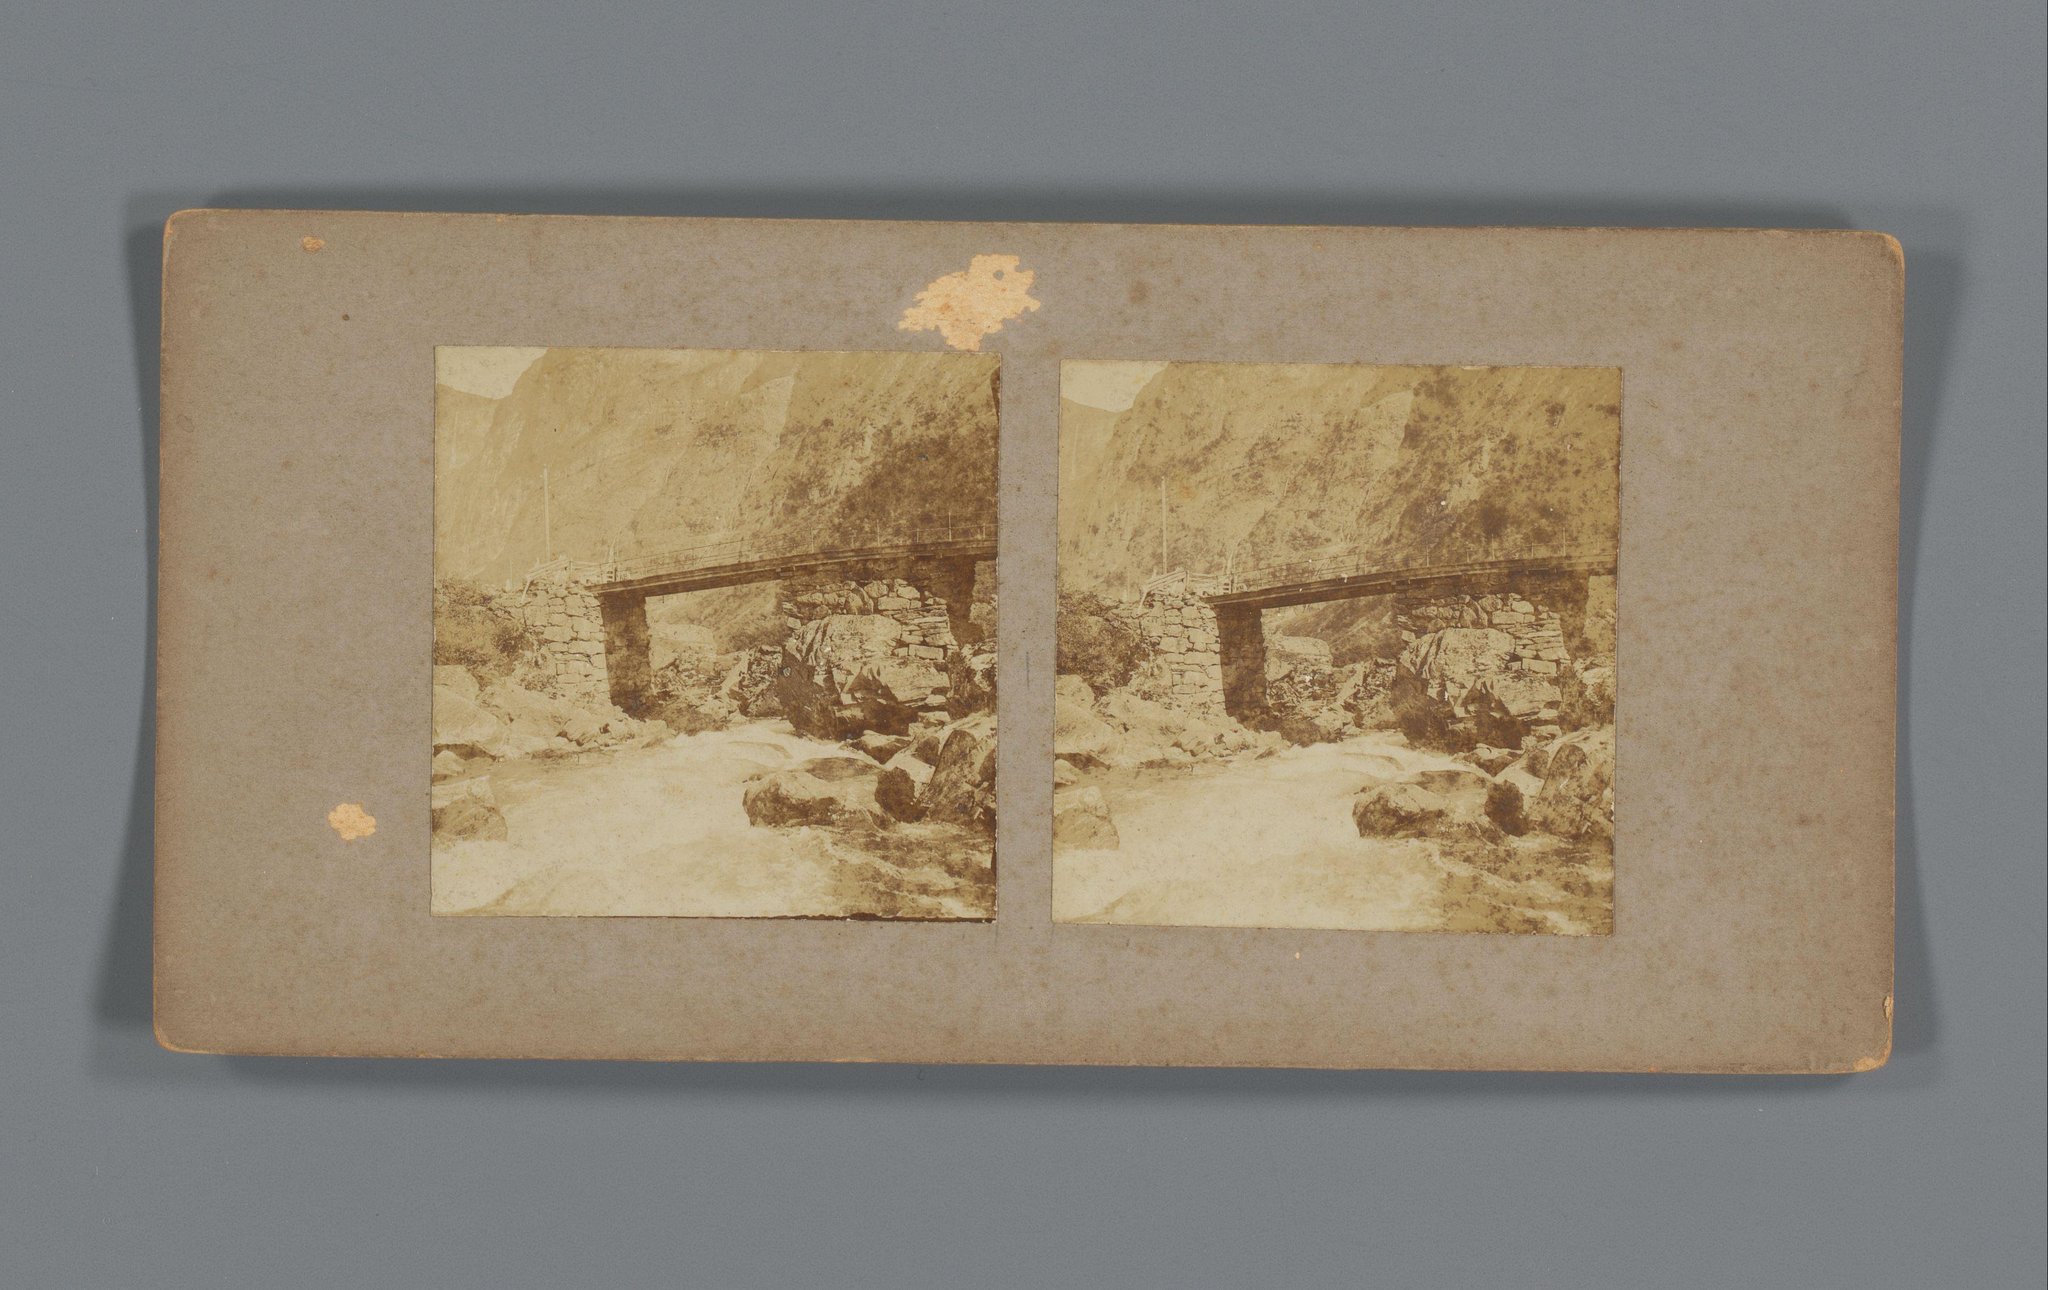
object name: stereograph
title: Brug over een rivier in het Nærøydal in Noorwegen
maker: Anonymous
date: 1882-1890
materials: cardboard, photographic support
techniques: collodion silver print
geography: nærøyfjord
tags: dale, valley, bridge